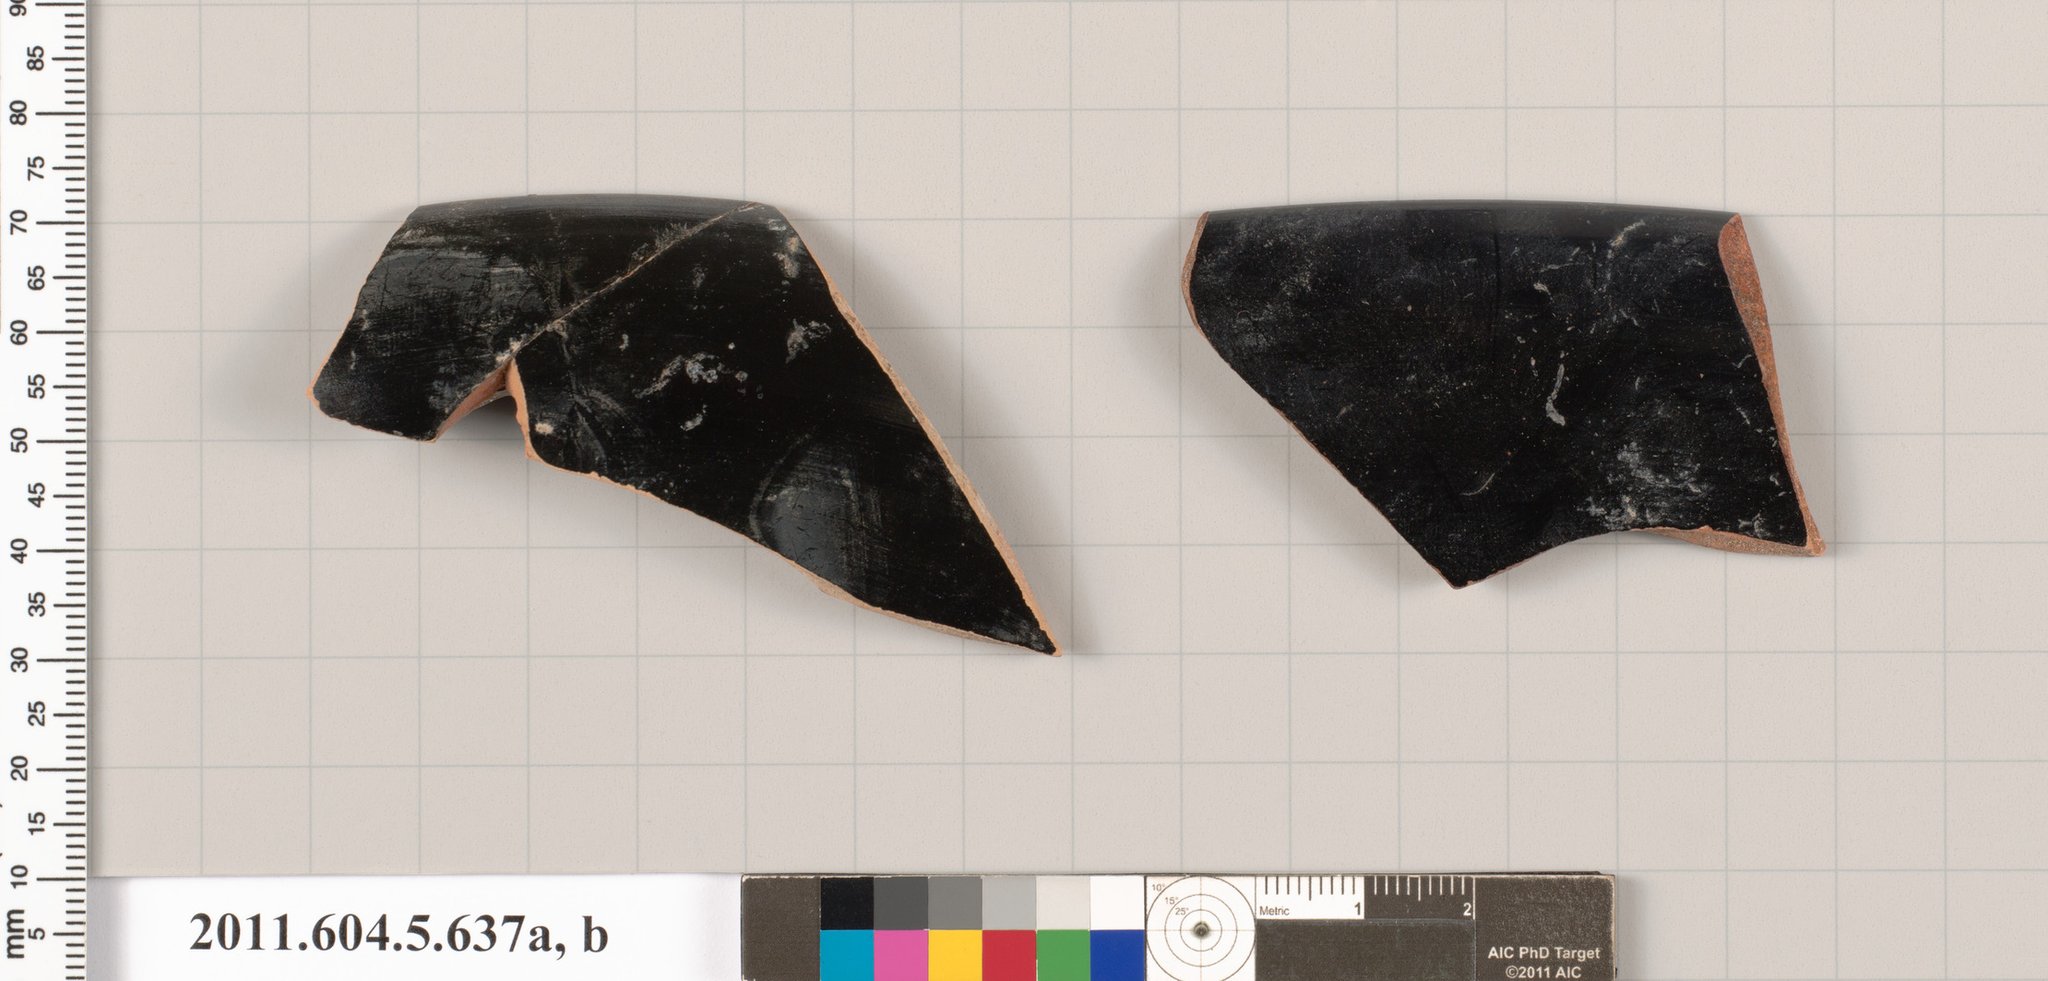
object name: kylix fragment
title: Terracotta rim fragments of kylikes (drinking cups)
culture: greek, attic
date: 600-401 BCE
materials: terracotta